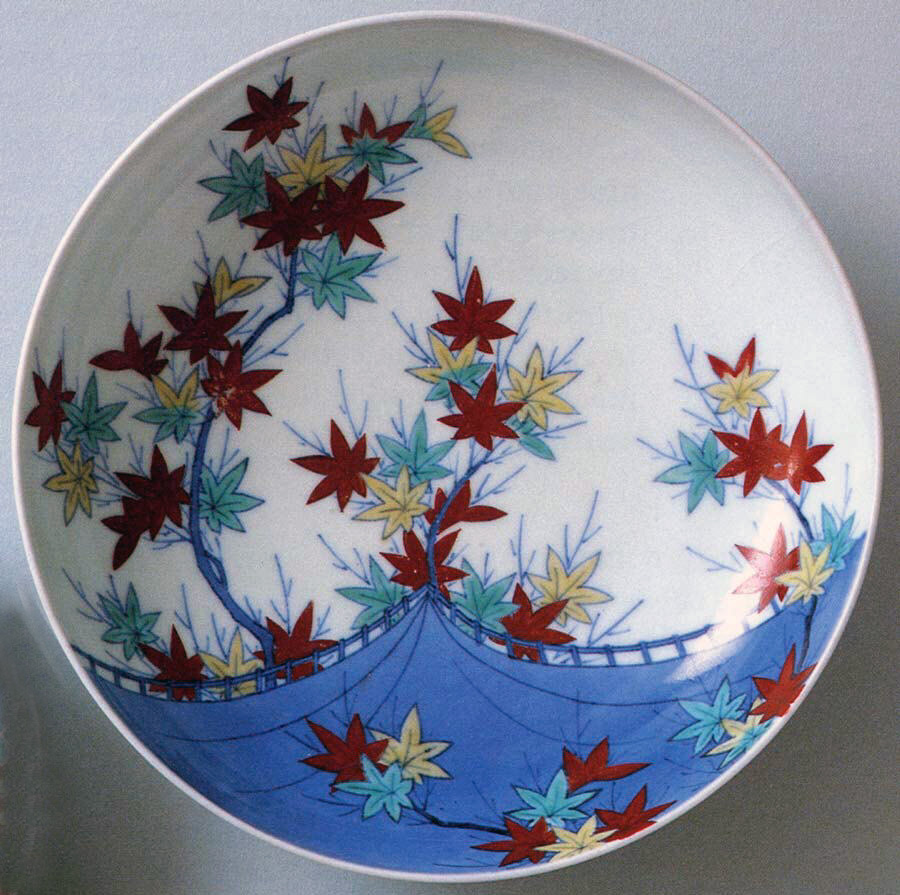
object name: dish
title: Dish with Design of Maple Leaves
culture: japanese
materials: enamel, porcelain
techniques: overglaze, underglaze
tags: leaves